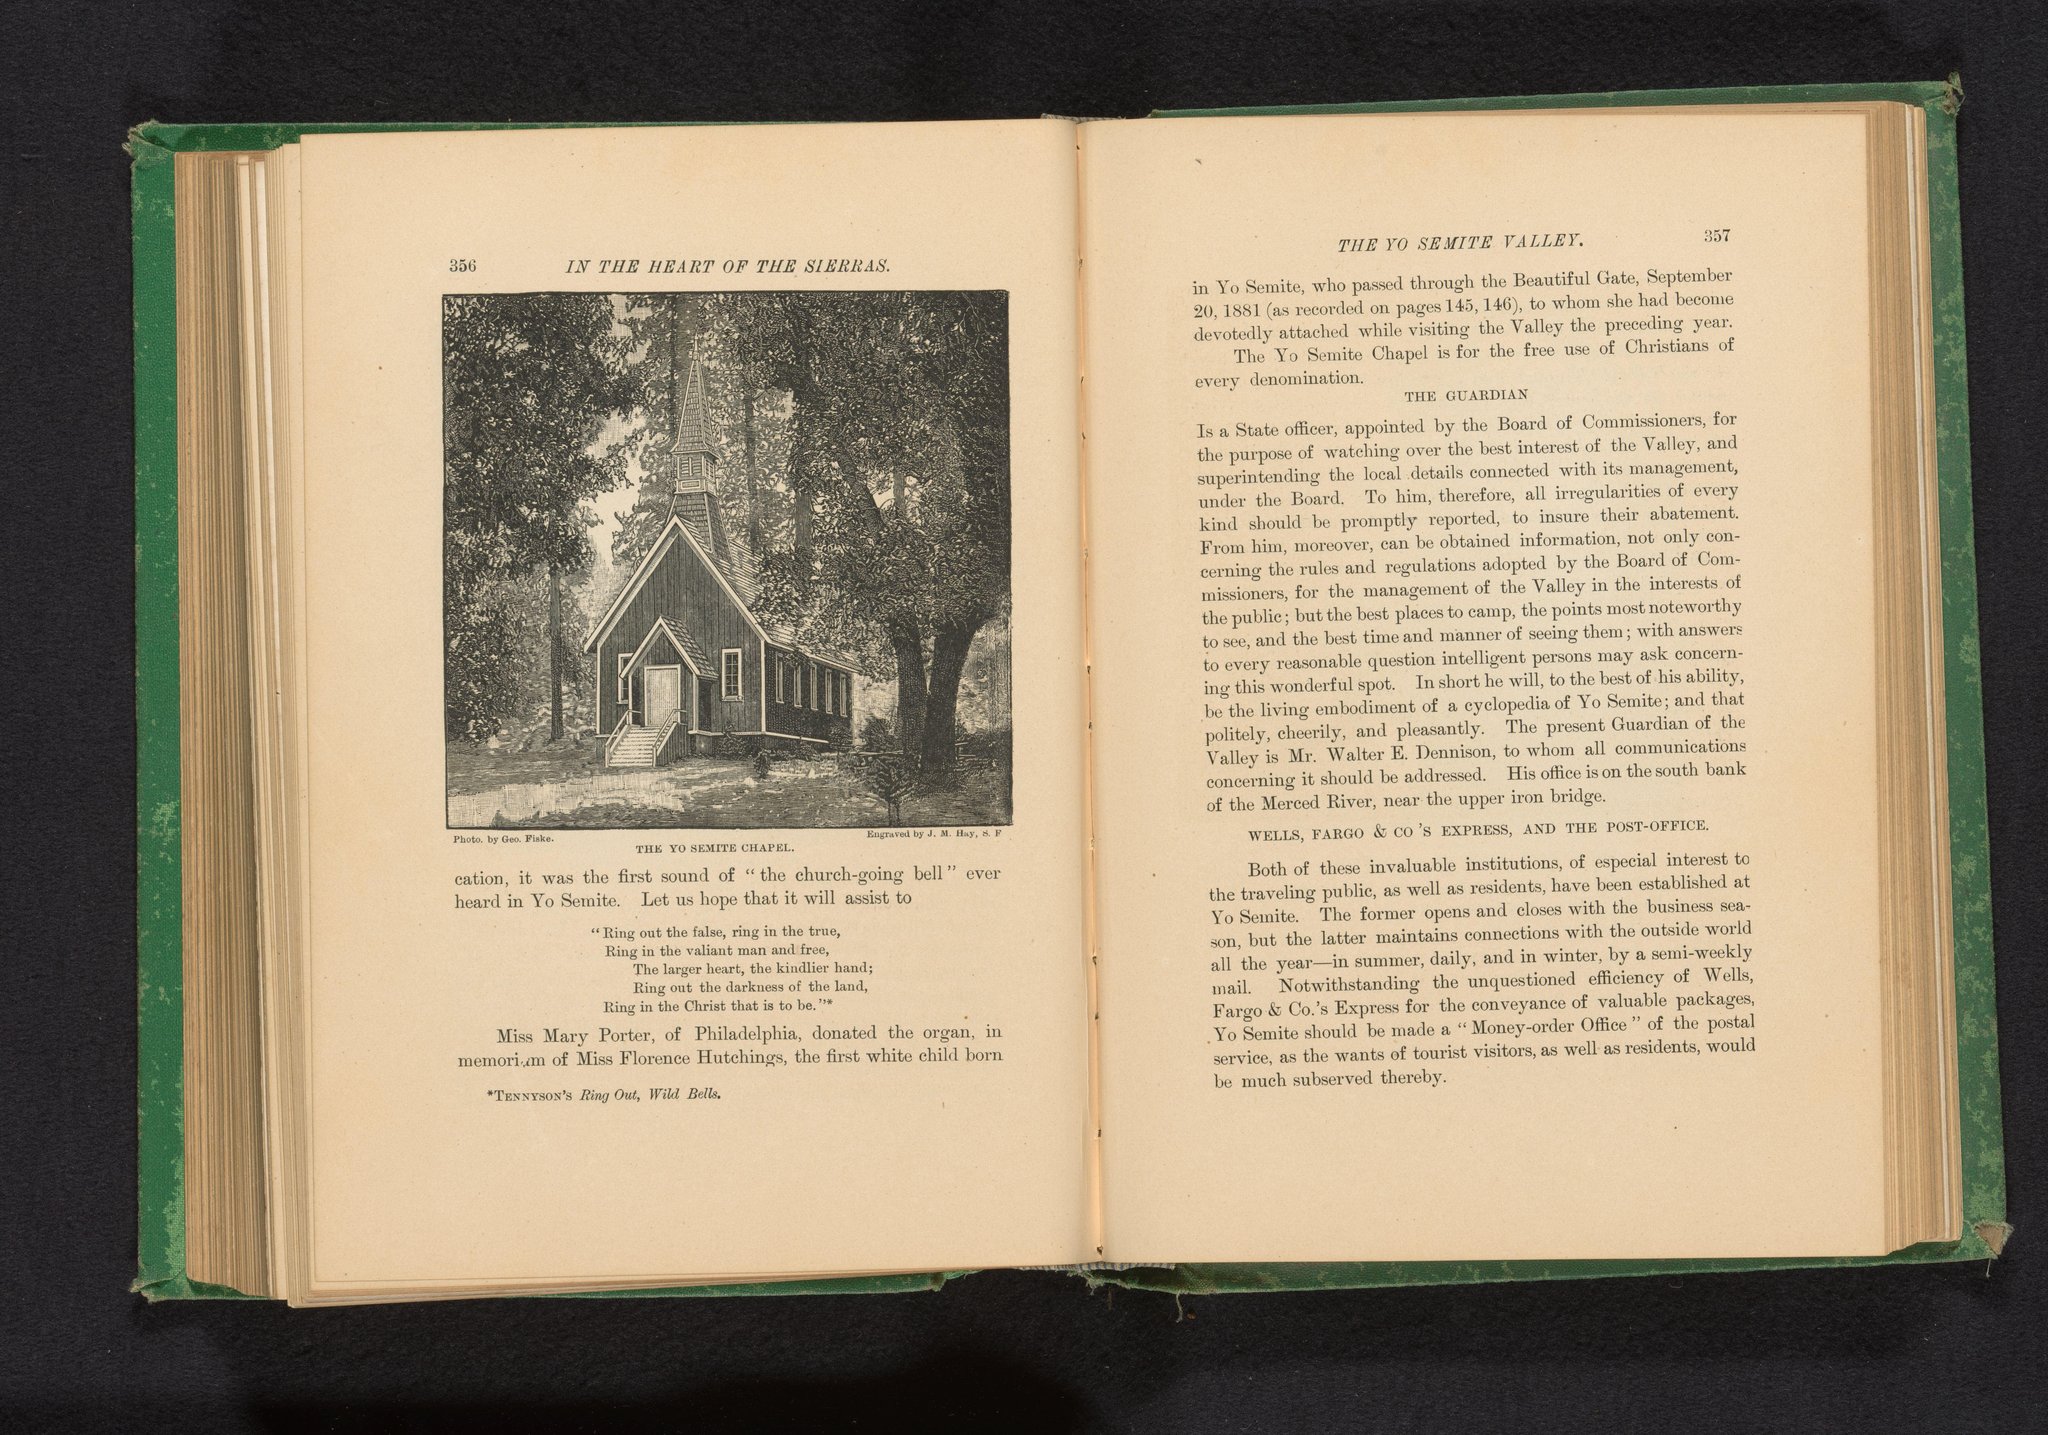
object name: page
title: The Yo Semite Chapel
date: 1881-1886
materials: paper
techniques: printing block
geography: yosemite valley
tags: forest, wood, church (exterior) - qq - small church, chapel